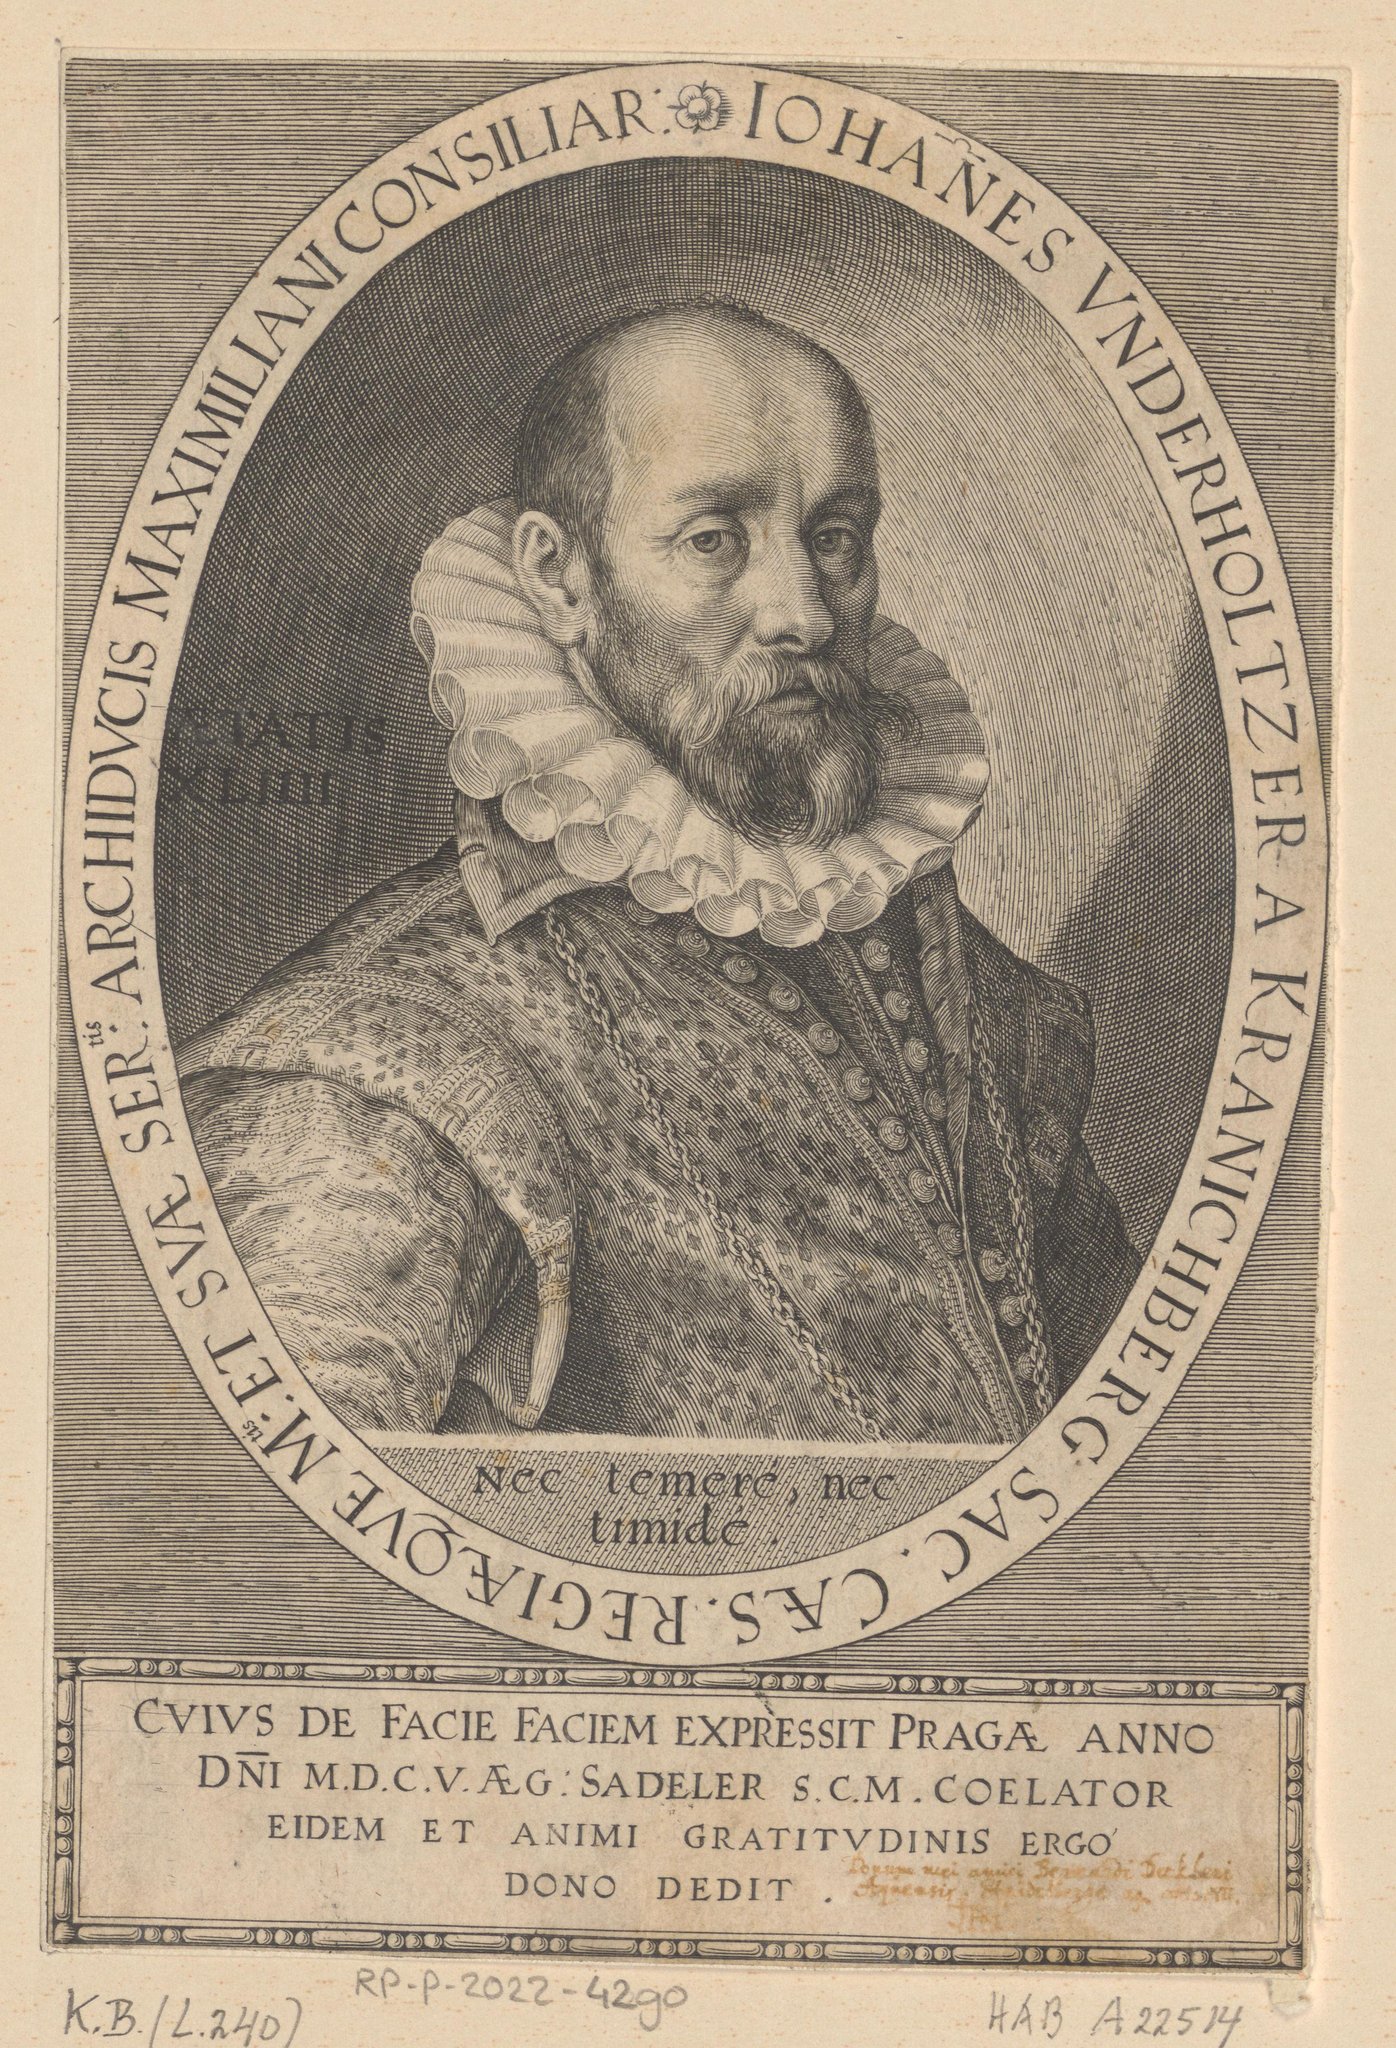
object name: print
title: Portret van Johann Underholtzer von Kranichberg op 44-jarige leeftijd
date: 1605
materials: paper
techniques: engraving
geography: prague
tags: earl, johan underholtzer von kranichberg, historical persons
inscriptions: inscription: ‘Donum mei amici Bernardi Dukkeri Aqu[...]nvir Heidelberge arts VII JA t.’, collector's mark: Lugt 240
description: Met vierregelig onderschrift in het Latijn.